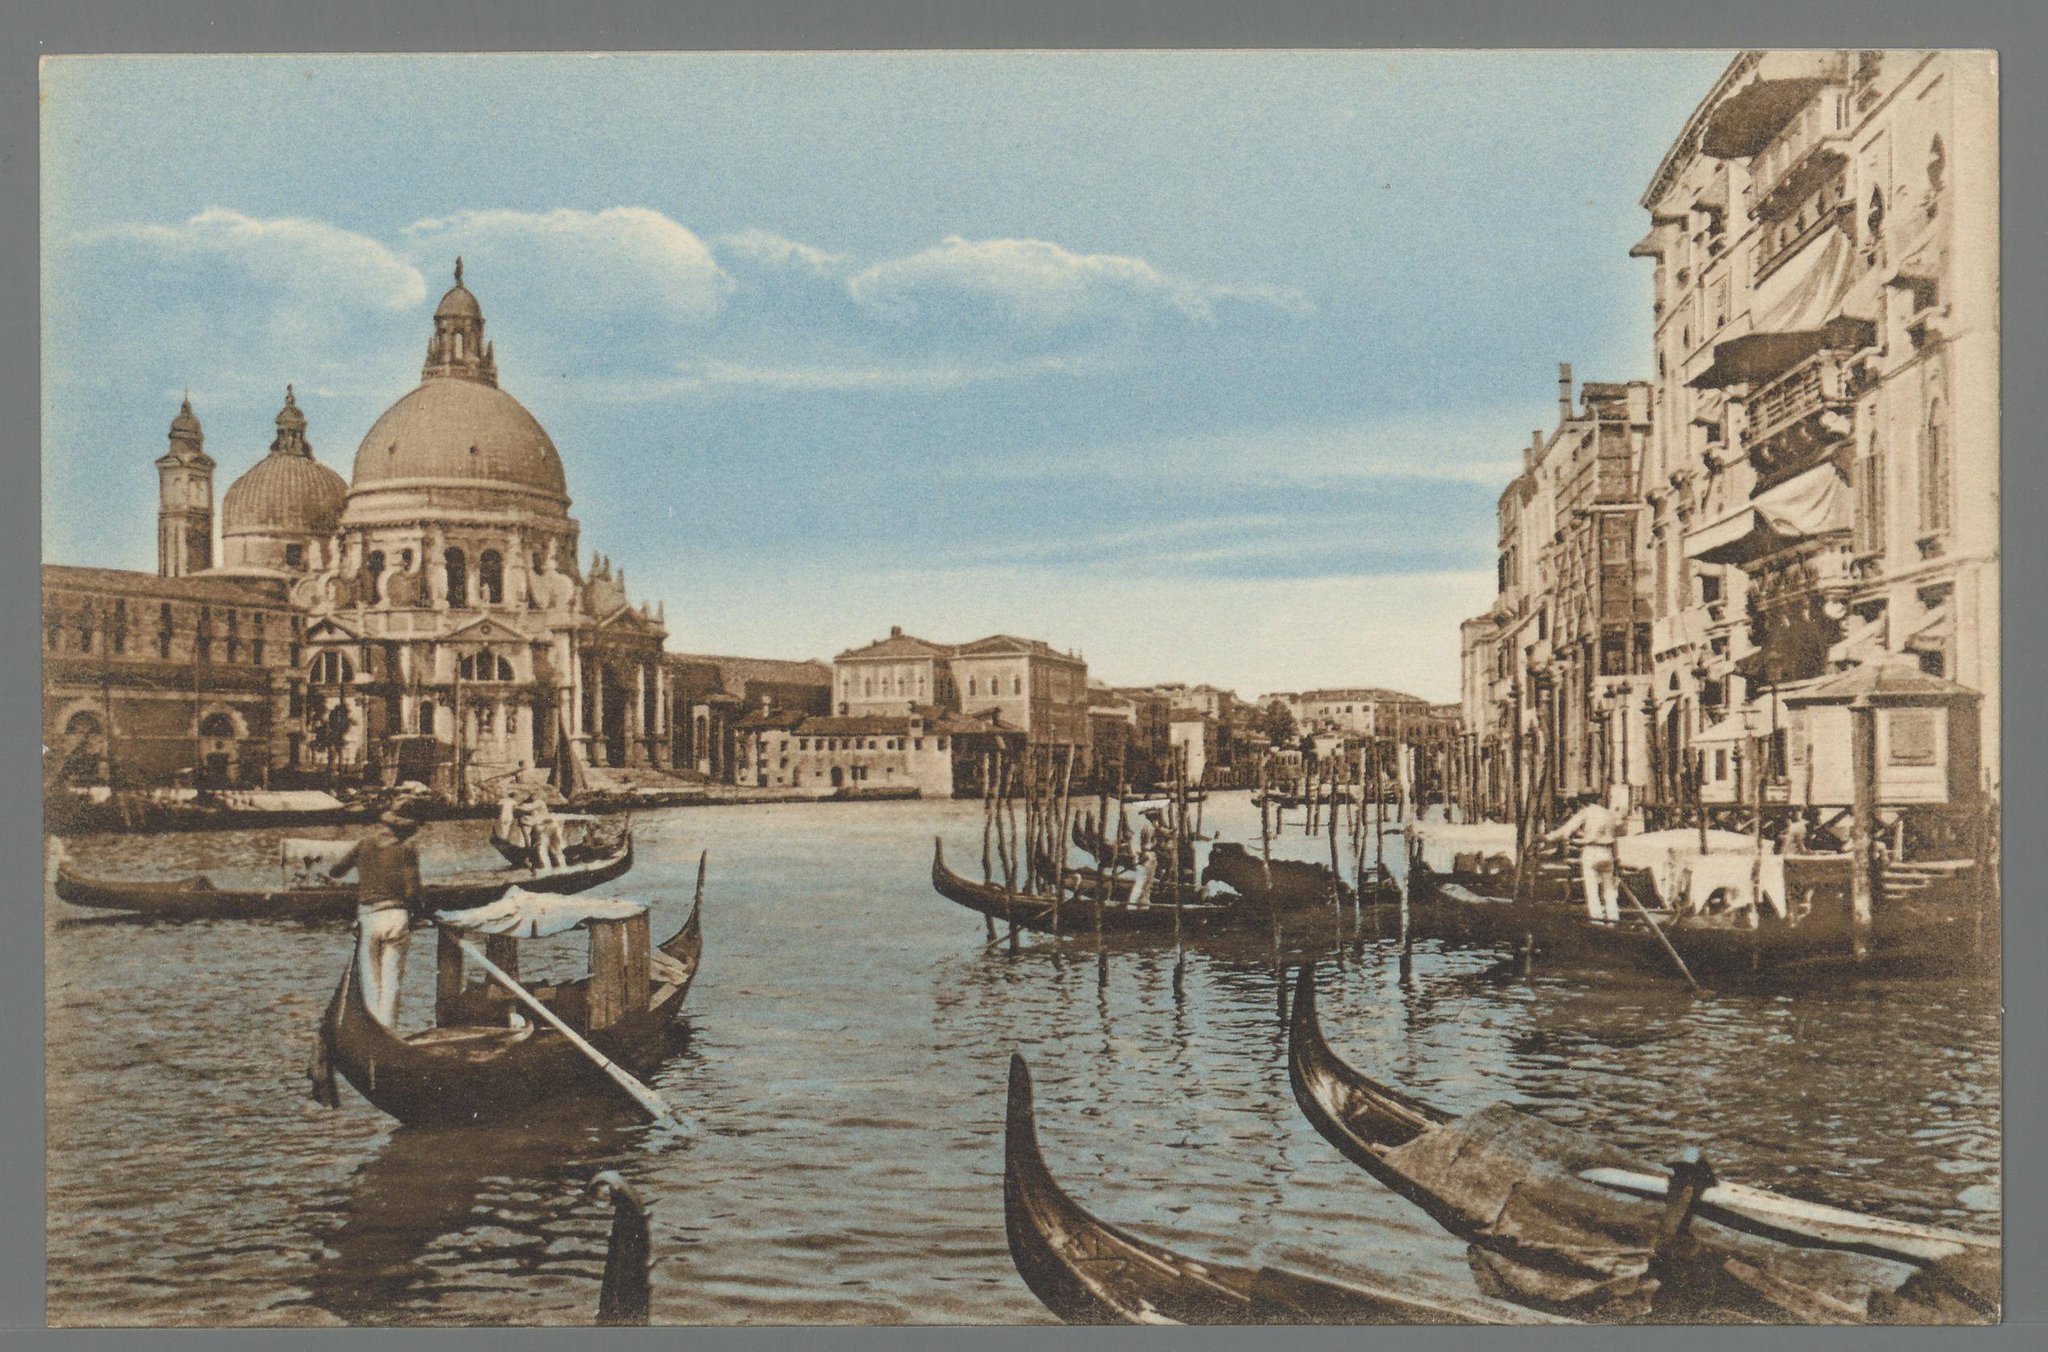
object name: photomechanical print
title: Venezia. Canal grande da calle Valaresso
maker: Anonymous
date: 1906-1920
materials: cardboard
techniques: photograph, lithograph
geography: venice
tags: canal, church (exterior), city-view, and landscape with man-made constructions (+ city(-scape) with figures, staffage)